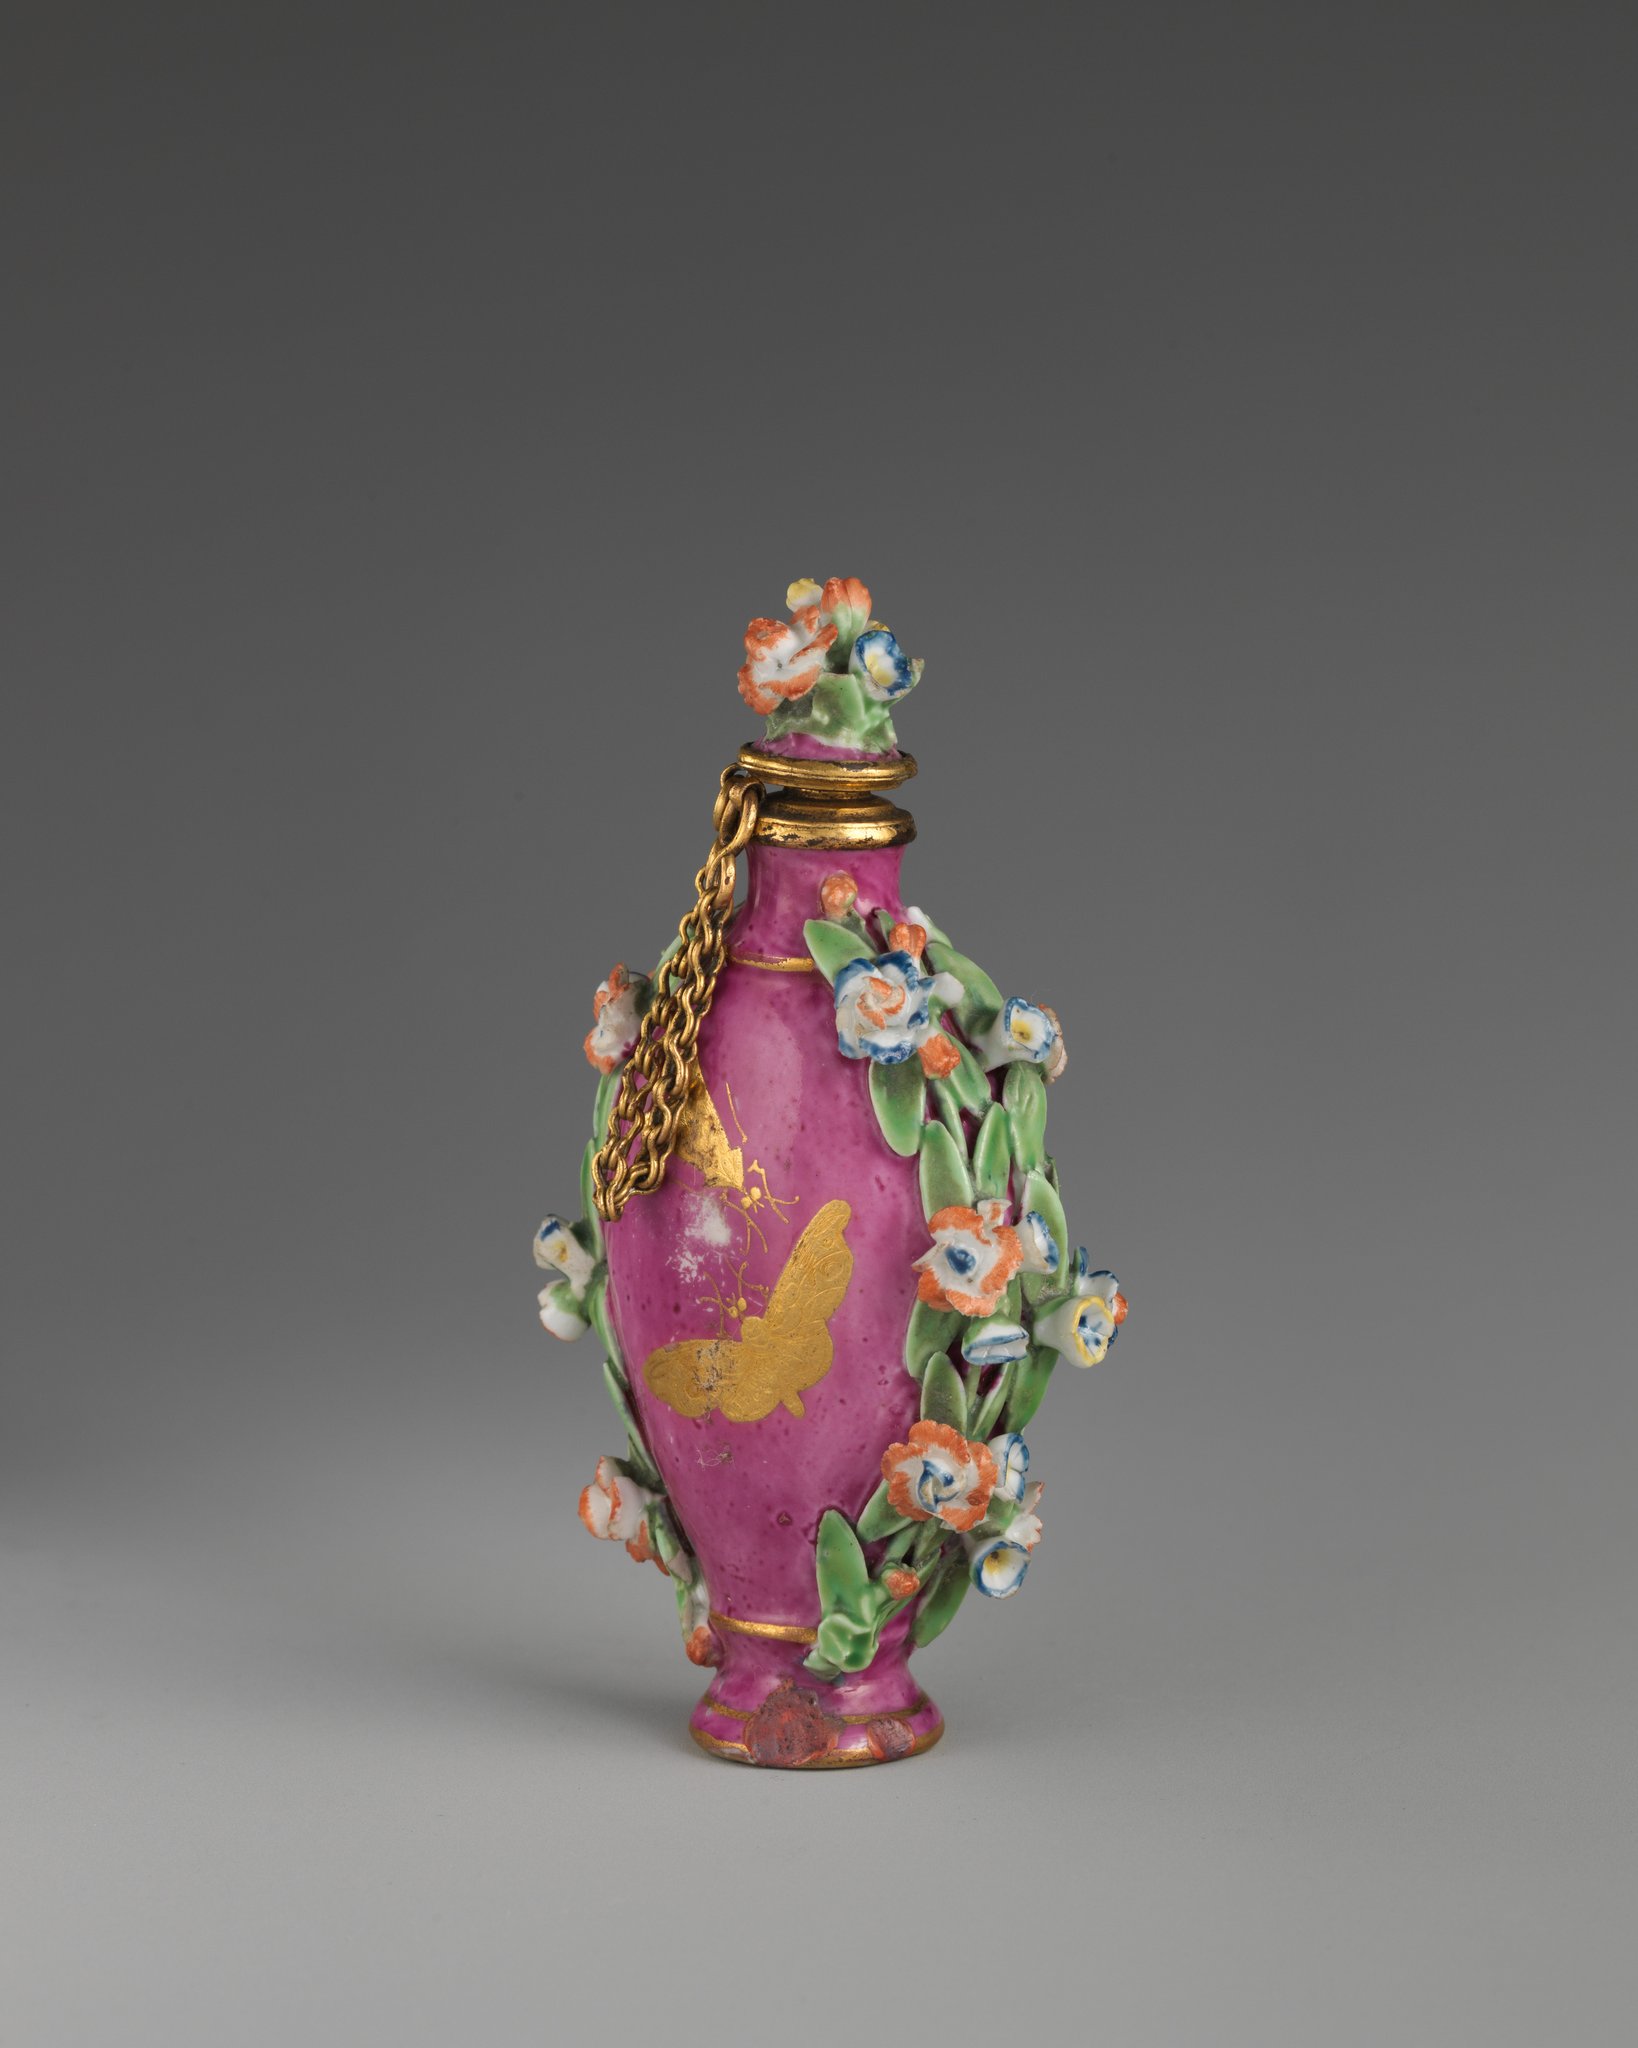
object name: toy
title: Flagon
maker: chelsea porcelain manufactory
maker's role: factory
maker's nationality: british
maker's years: 1744-1784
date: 1765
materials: soft paste porcelain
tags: butterflies,flowers